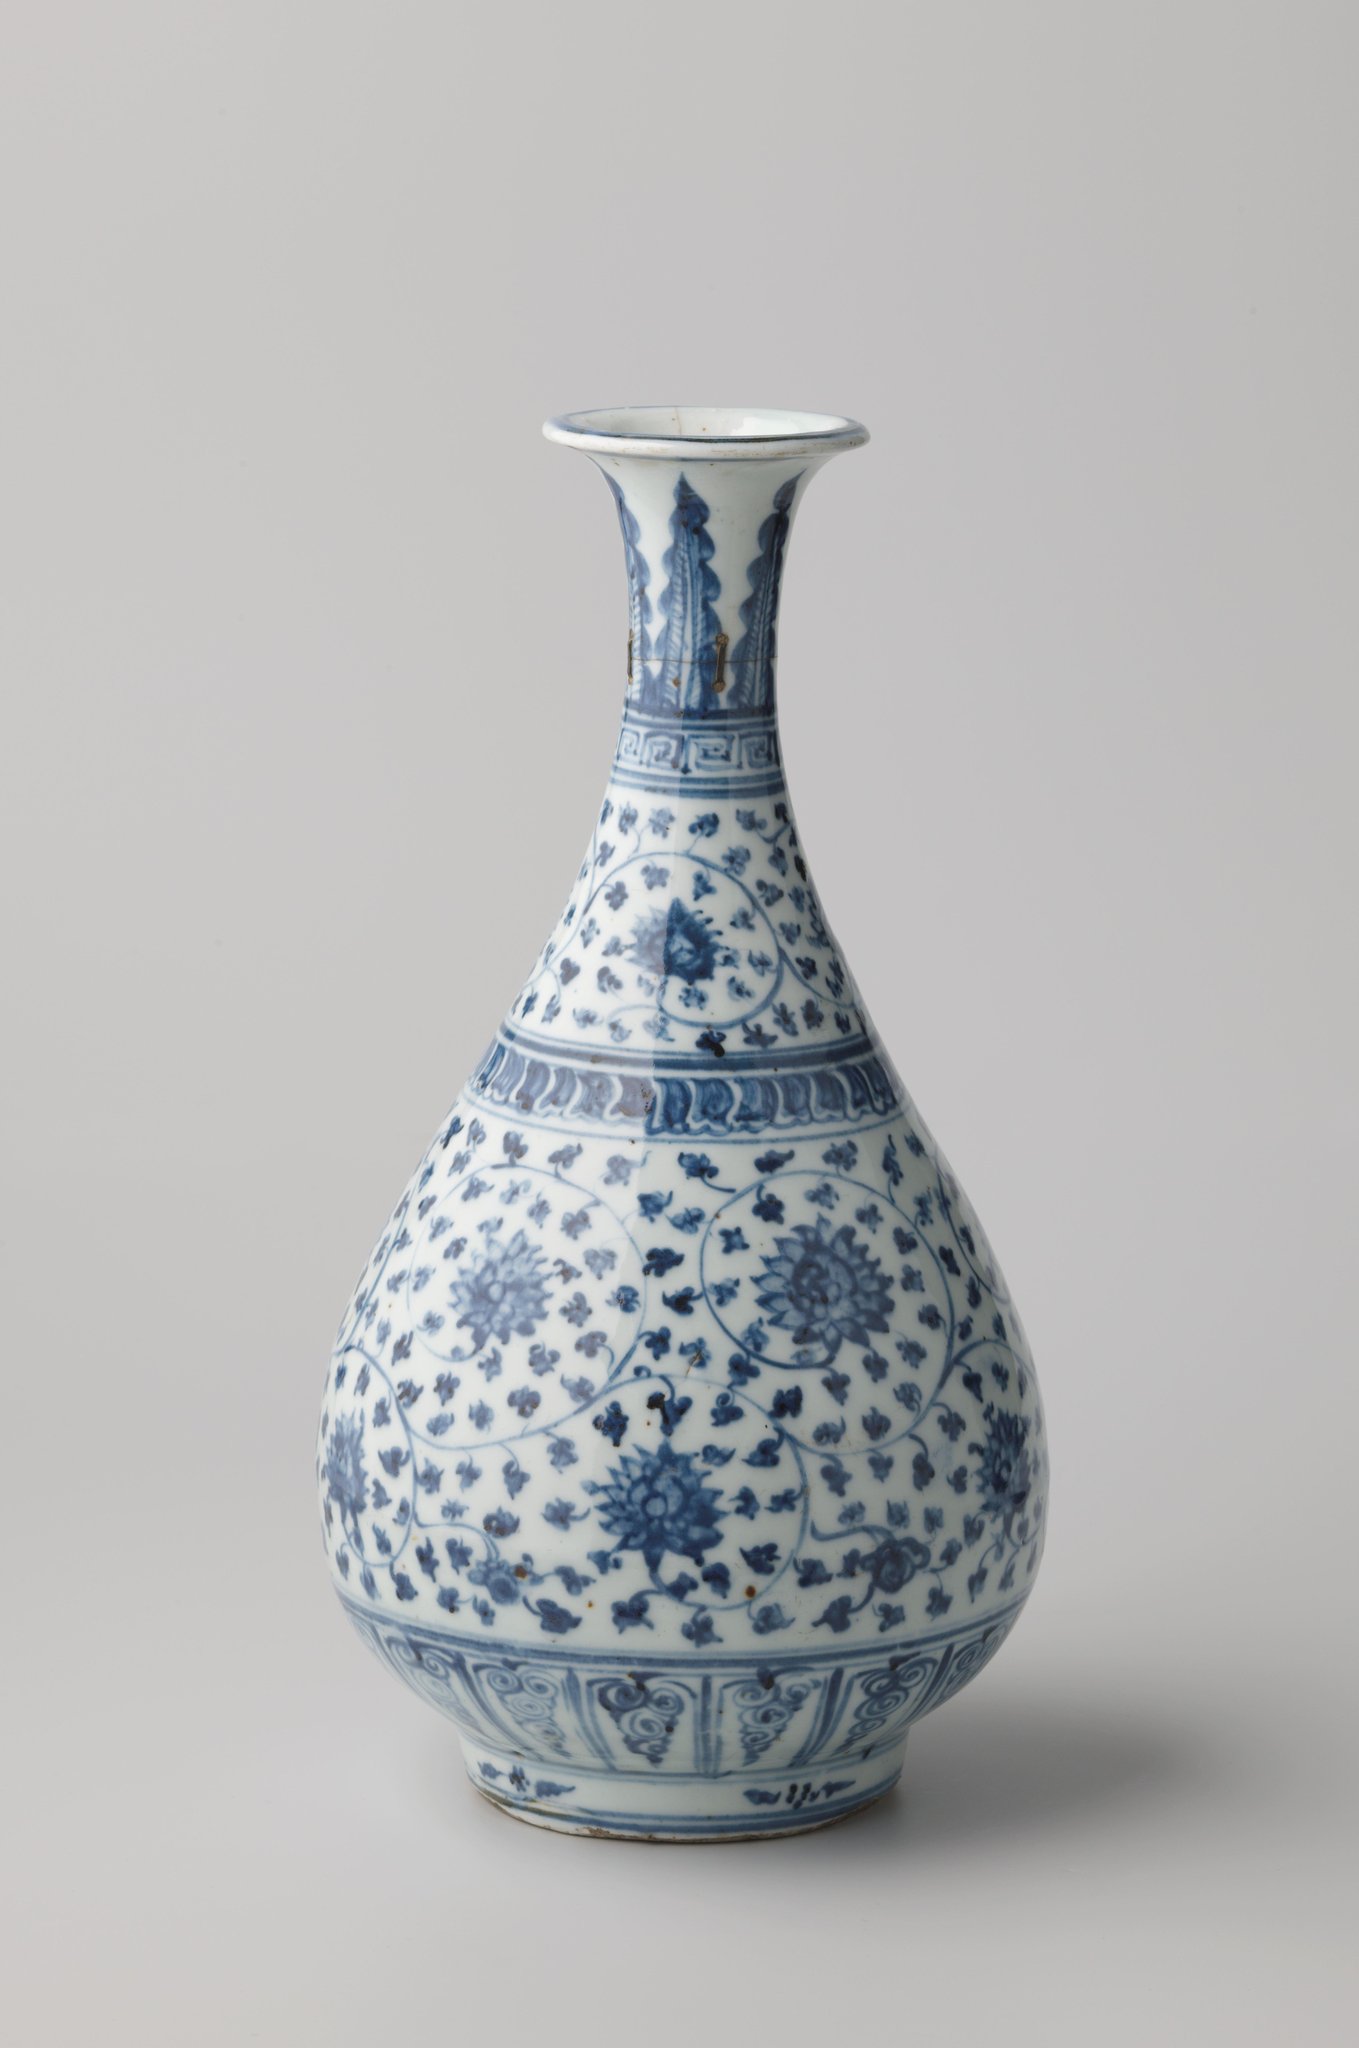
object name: bottle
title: Pear-shaped bottle vase with continuous lotus scrolls and ornamental borders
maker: Anonymous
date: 1500-1599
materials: cobalt, glaze, paint, porcelain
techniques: firing, turning, vitrification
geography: china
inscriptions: mark: ‘大 明 年 製 (?)’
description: Fles, met onderglazuur blauw in perzische trant.Met gestileerde bladranken.